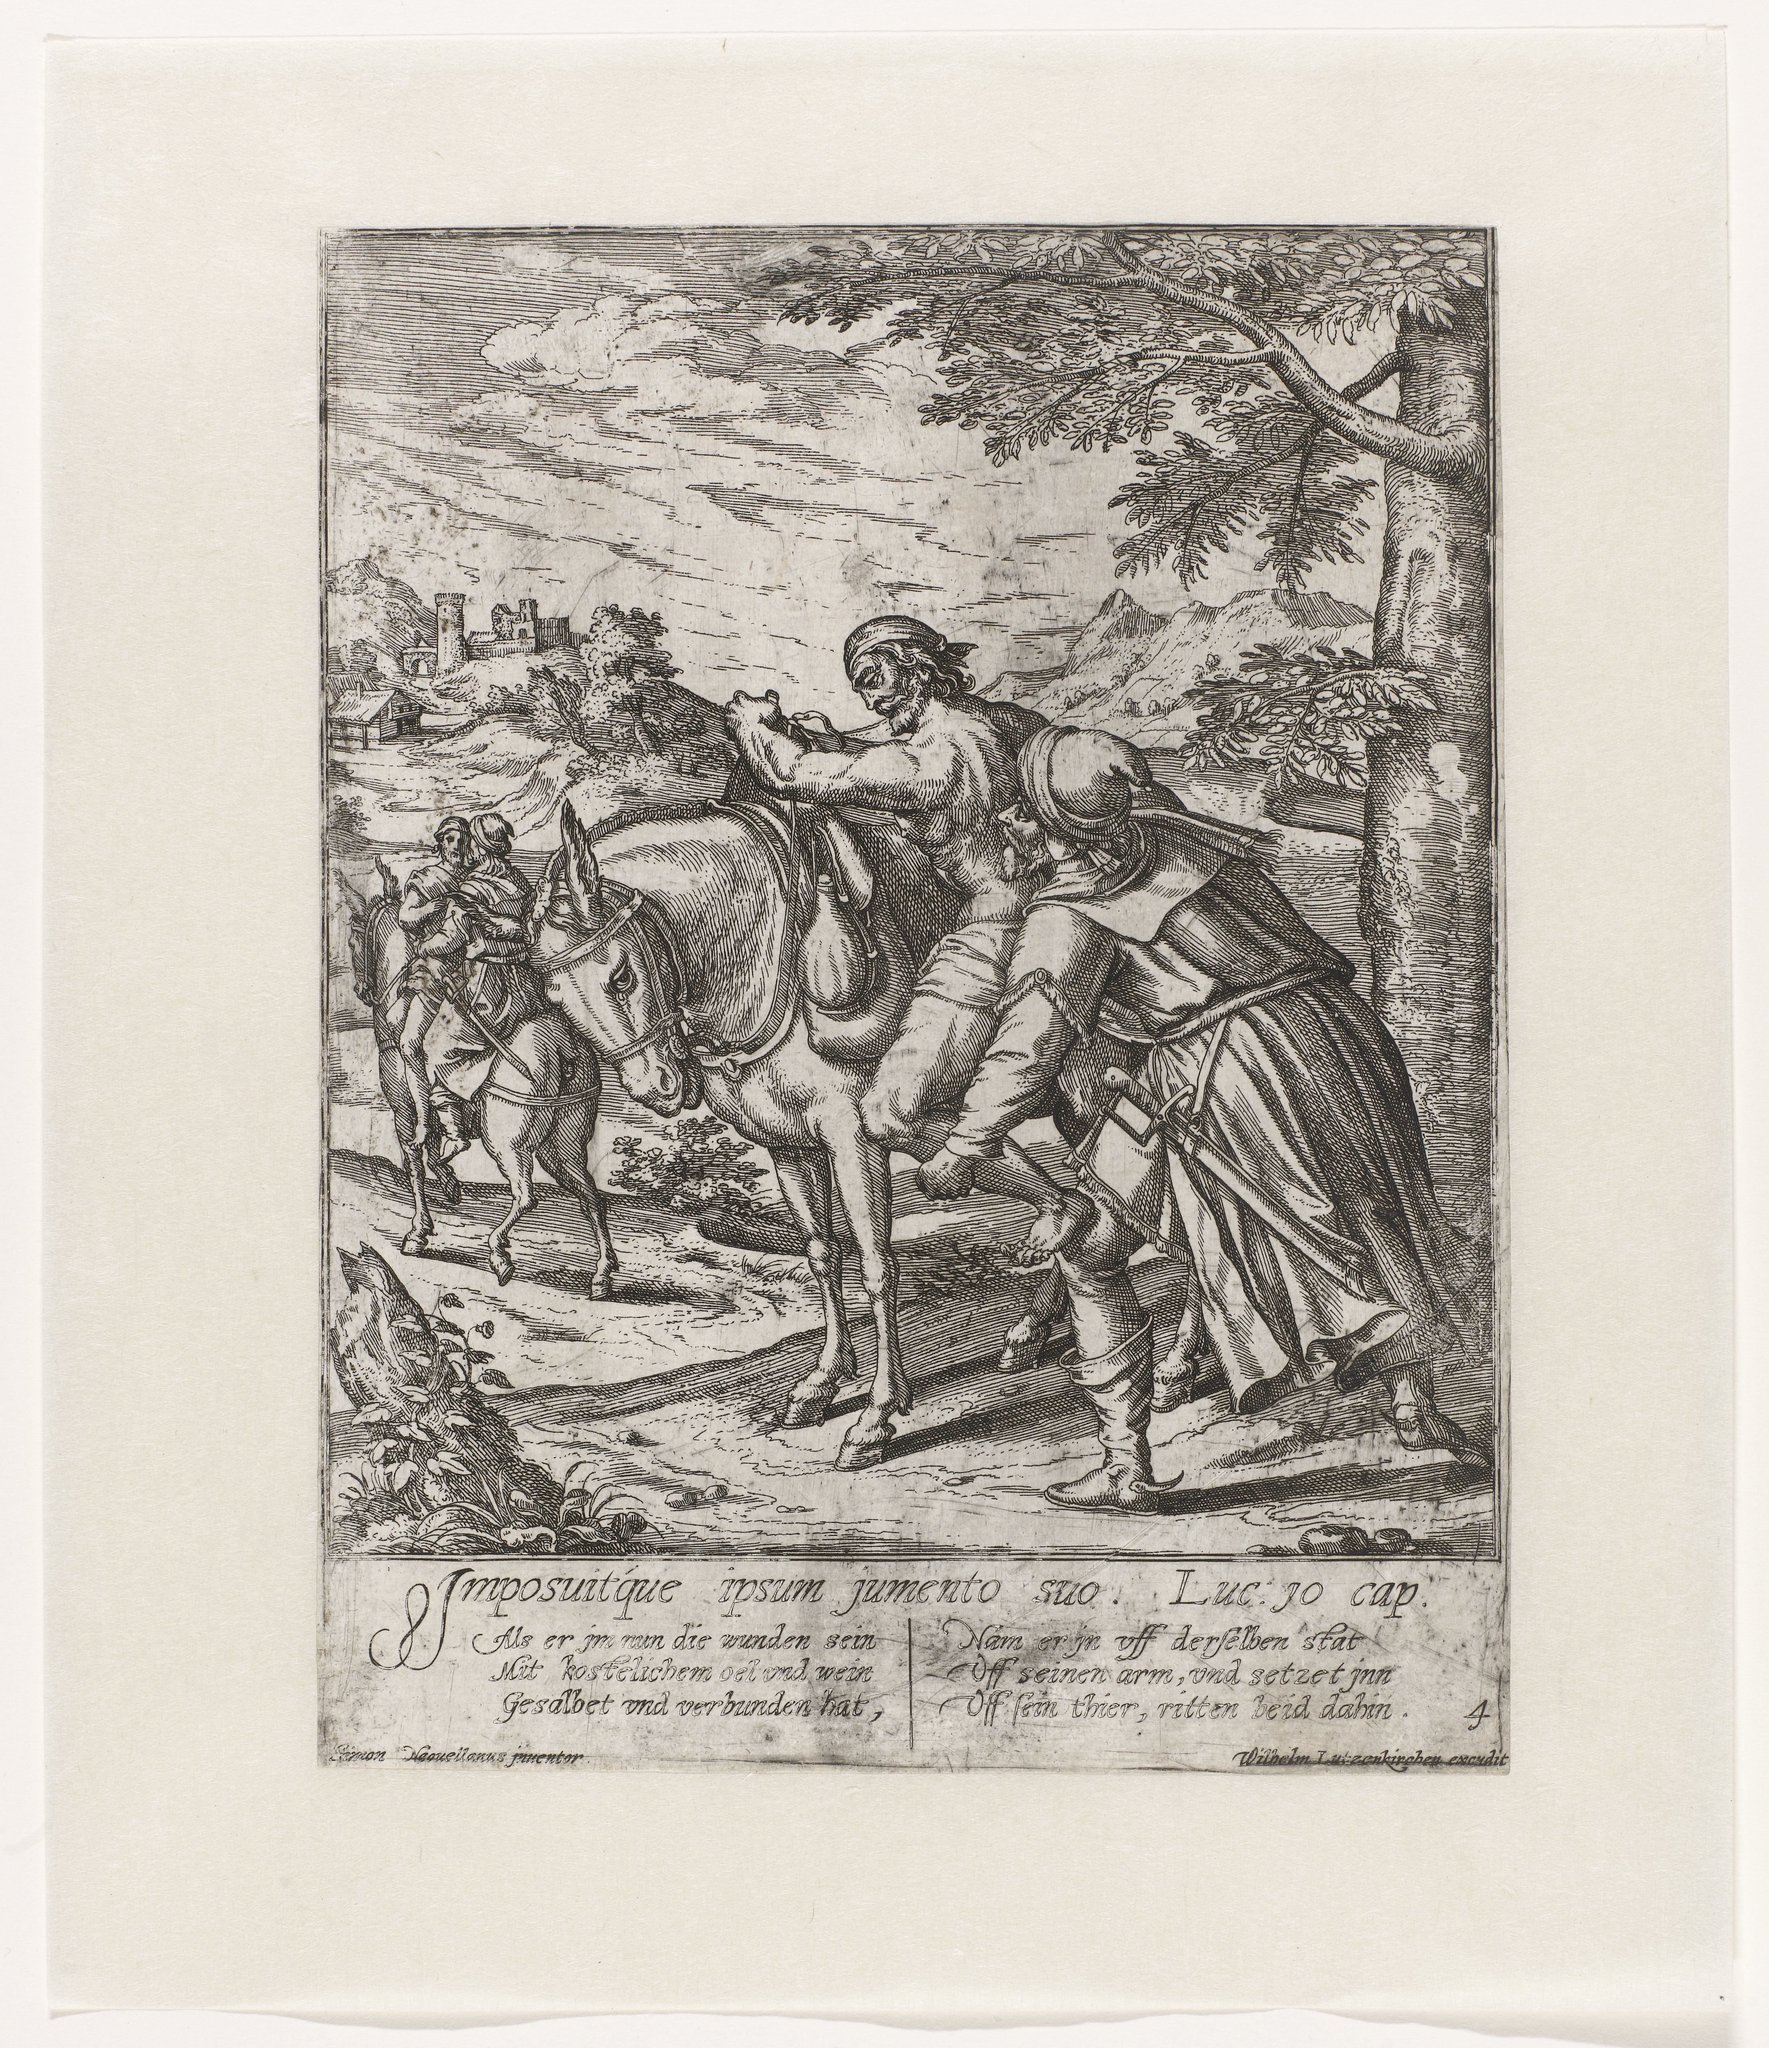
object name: print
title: De barmhartige Samaritaan helpt de gewonde man op zijn ezel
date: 1560-1590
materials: paper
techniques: etching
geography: cologne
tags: ass, donkey, the samaritan sets the wounded traveller on his mount (ass or horse), and brings him to an inn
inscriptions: collector's mark: Lugt 2228, collector's mark: Lugt 2228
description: De barmhartige Samaritaan helpt de gewonde reiziger op de ezel. Op het tweede plan rijden beiden op de ezel in de richting van de stad Jeruzalem. Onder de afbeelding een tweeregelige tekst in het Latijn uit Luc. 10 en een zesregelig vers in het Duits.